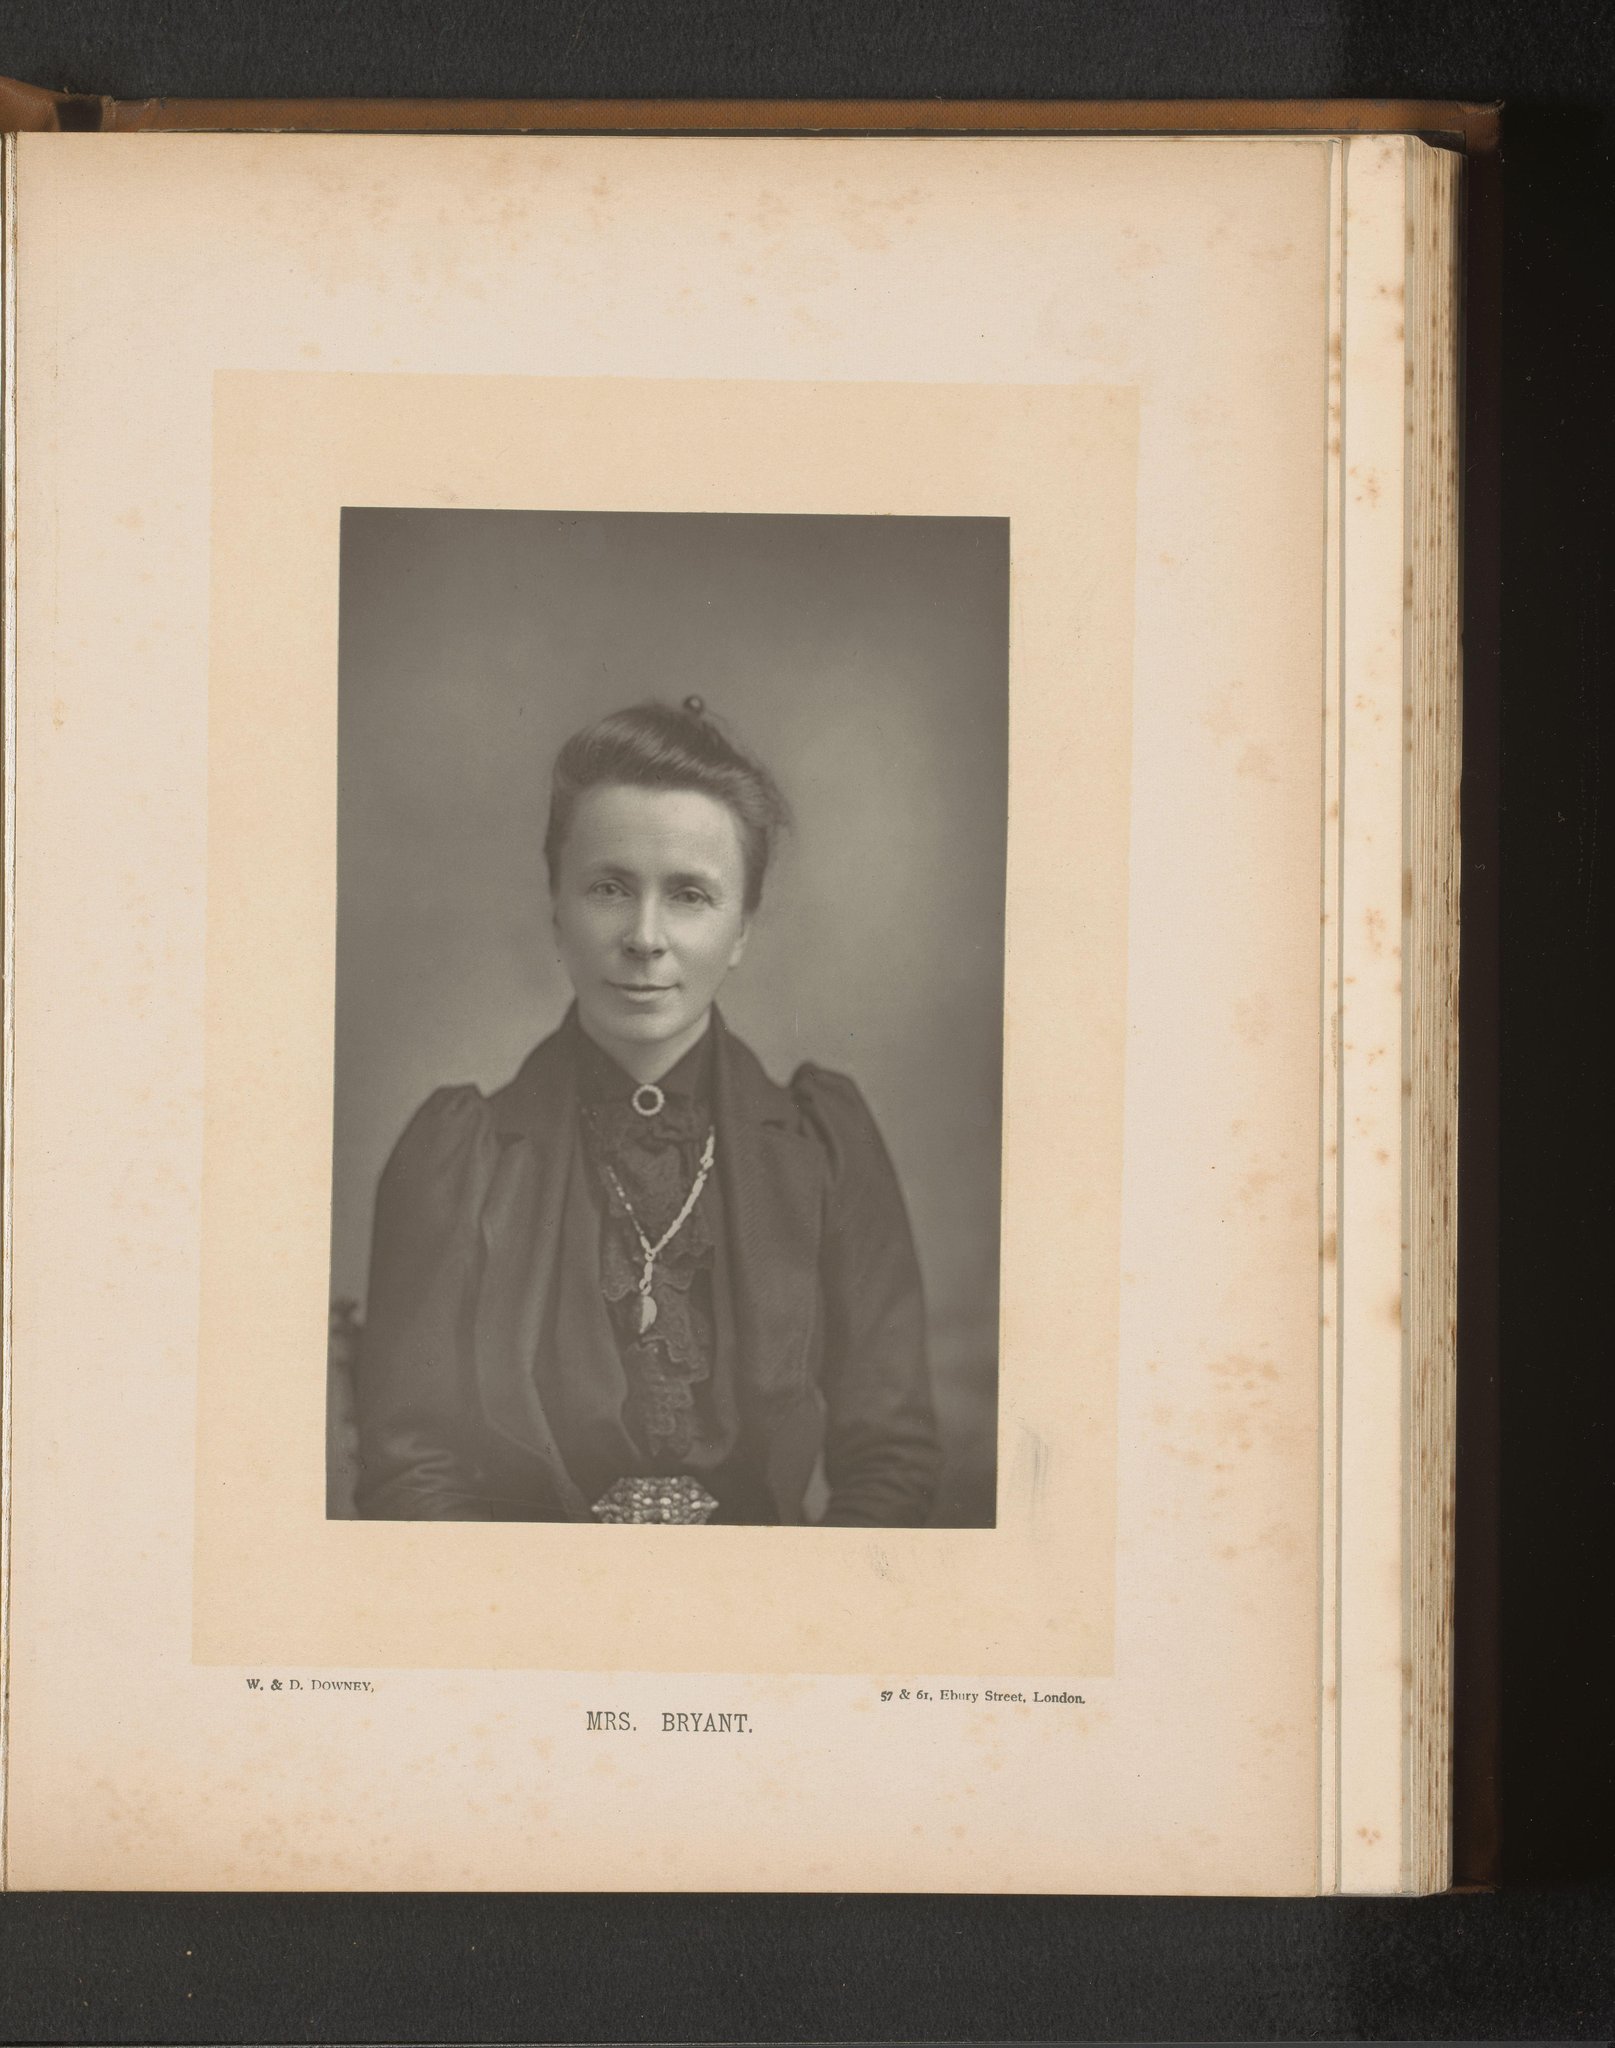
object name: page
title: Mrs. Bryant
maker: Anonymous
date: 1884-1894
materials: paper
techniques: woodburytype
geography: london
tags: mathematics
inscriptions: inscription: ‘57 & 61, Elbury Street, London.’